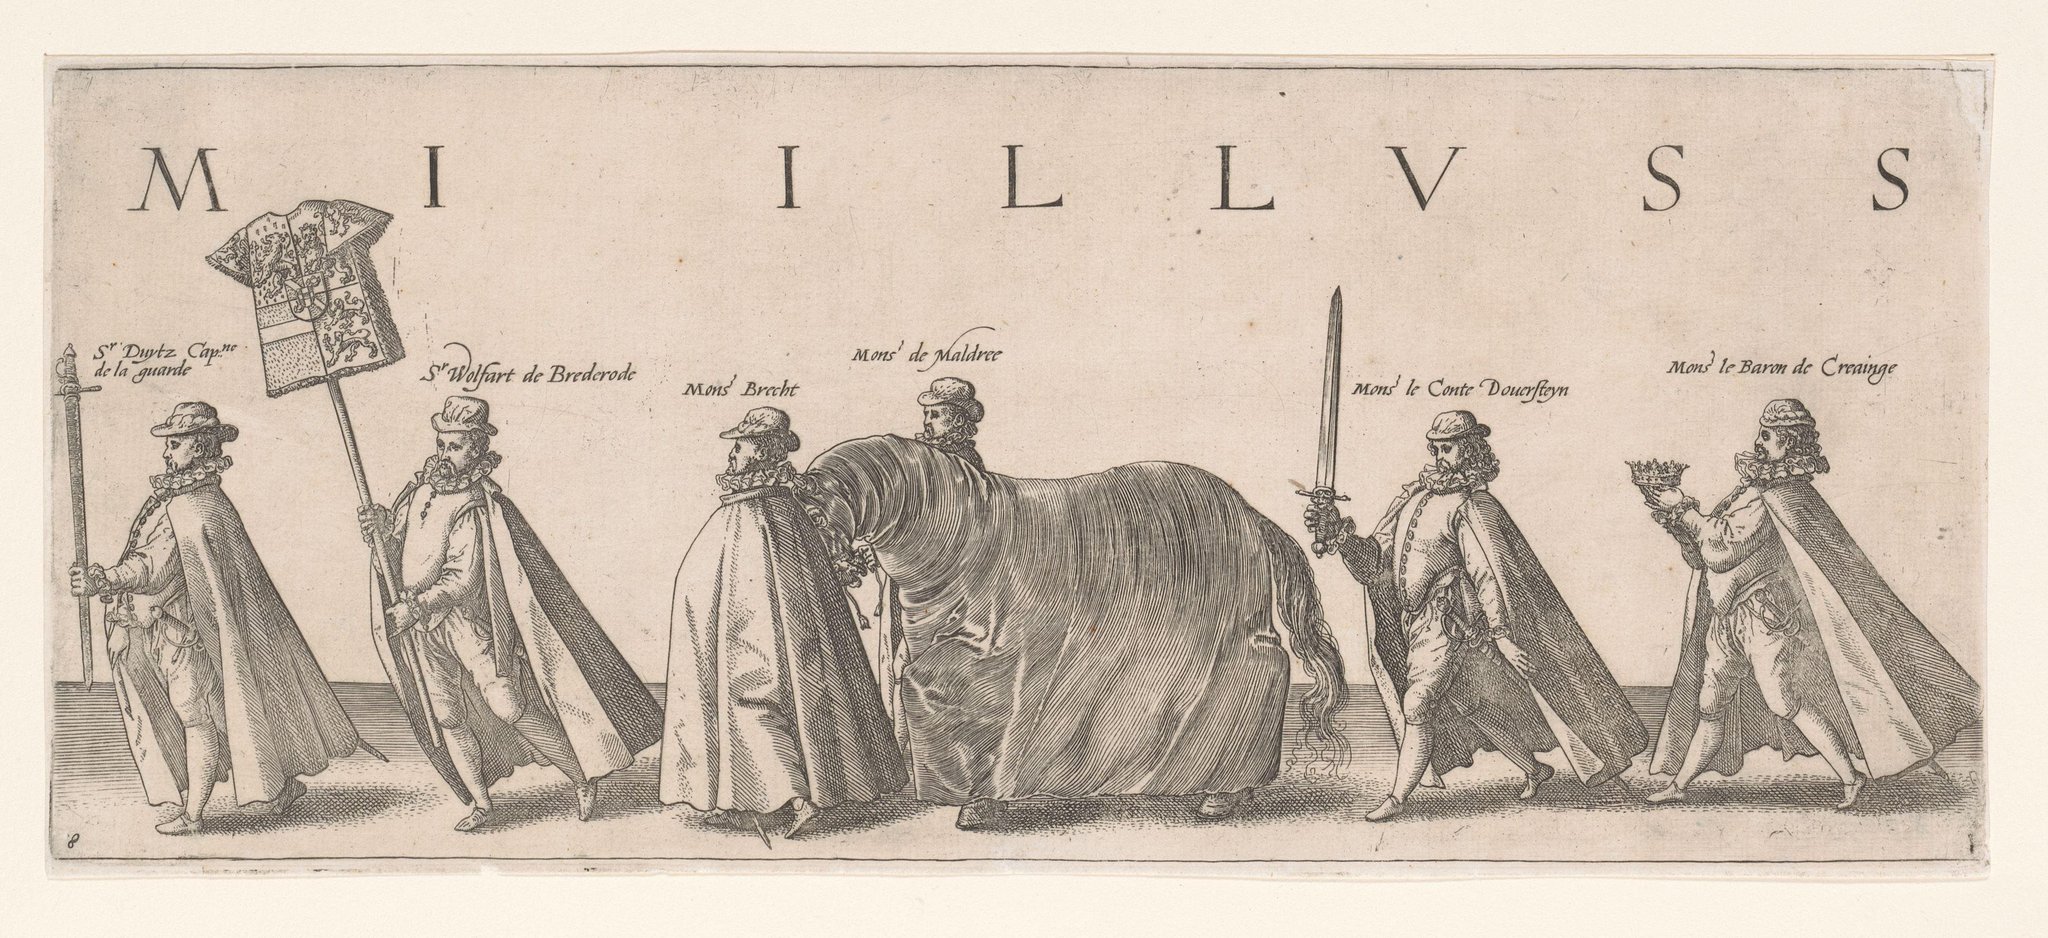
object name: print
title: De begrafenisstoet van Willem van Oranje, 3 augustus 1584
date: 1584-1638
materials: paper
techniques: engraving, etching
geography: haarlem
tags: delft, william i (prince of orange), cortege, funeral procession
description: Lijkstatie met de heren Duytz, Wolfart van Brederode, Brecht, de Maldree, de graaf van Oversteyn en de Baron de Creainge. Zij dragen bij zich twee zwaarden, de wapenrok, het paard en de kroon van de prins. Blad 8 in de begrafenisstoet van Willem van Oranje, Delft 3 augustus 1584.